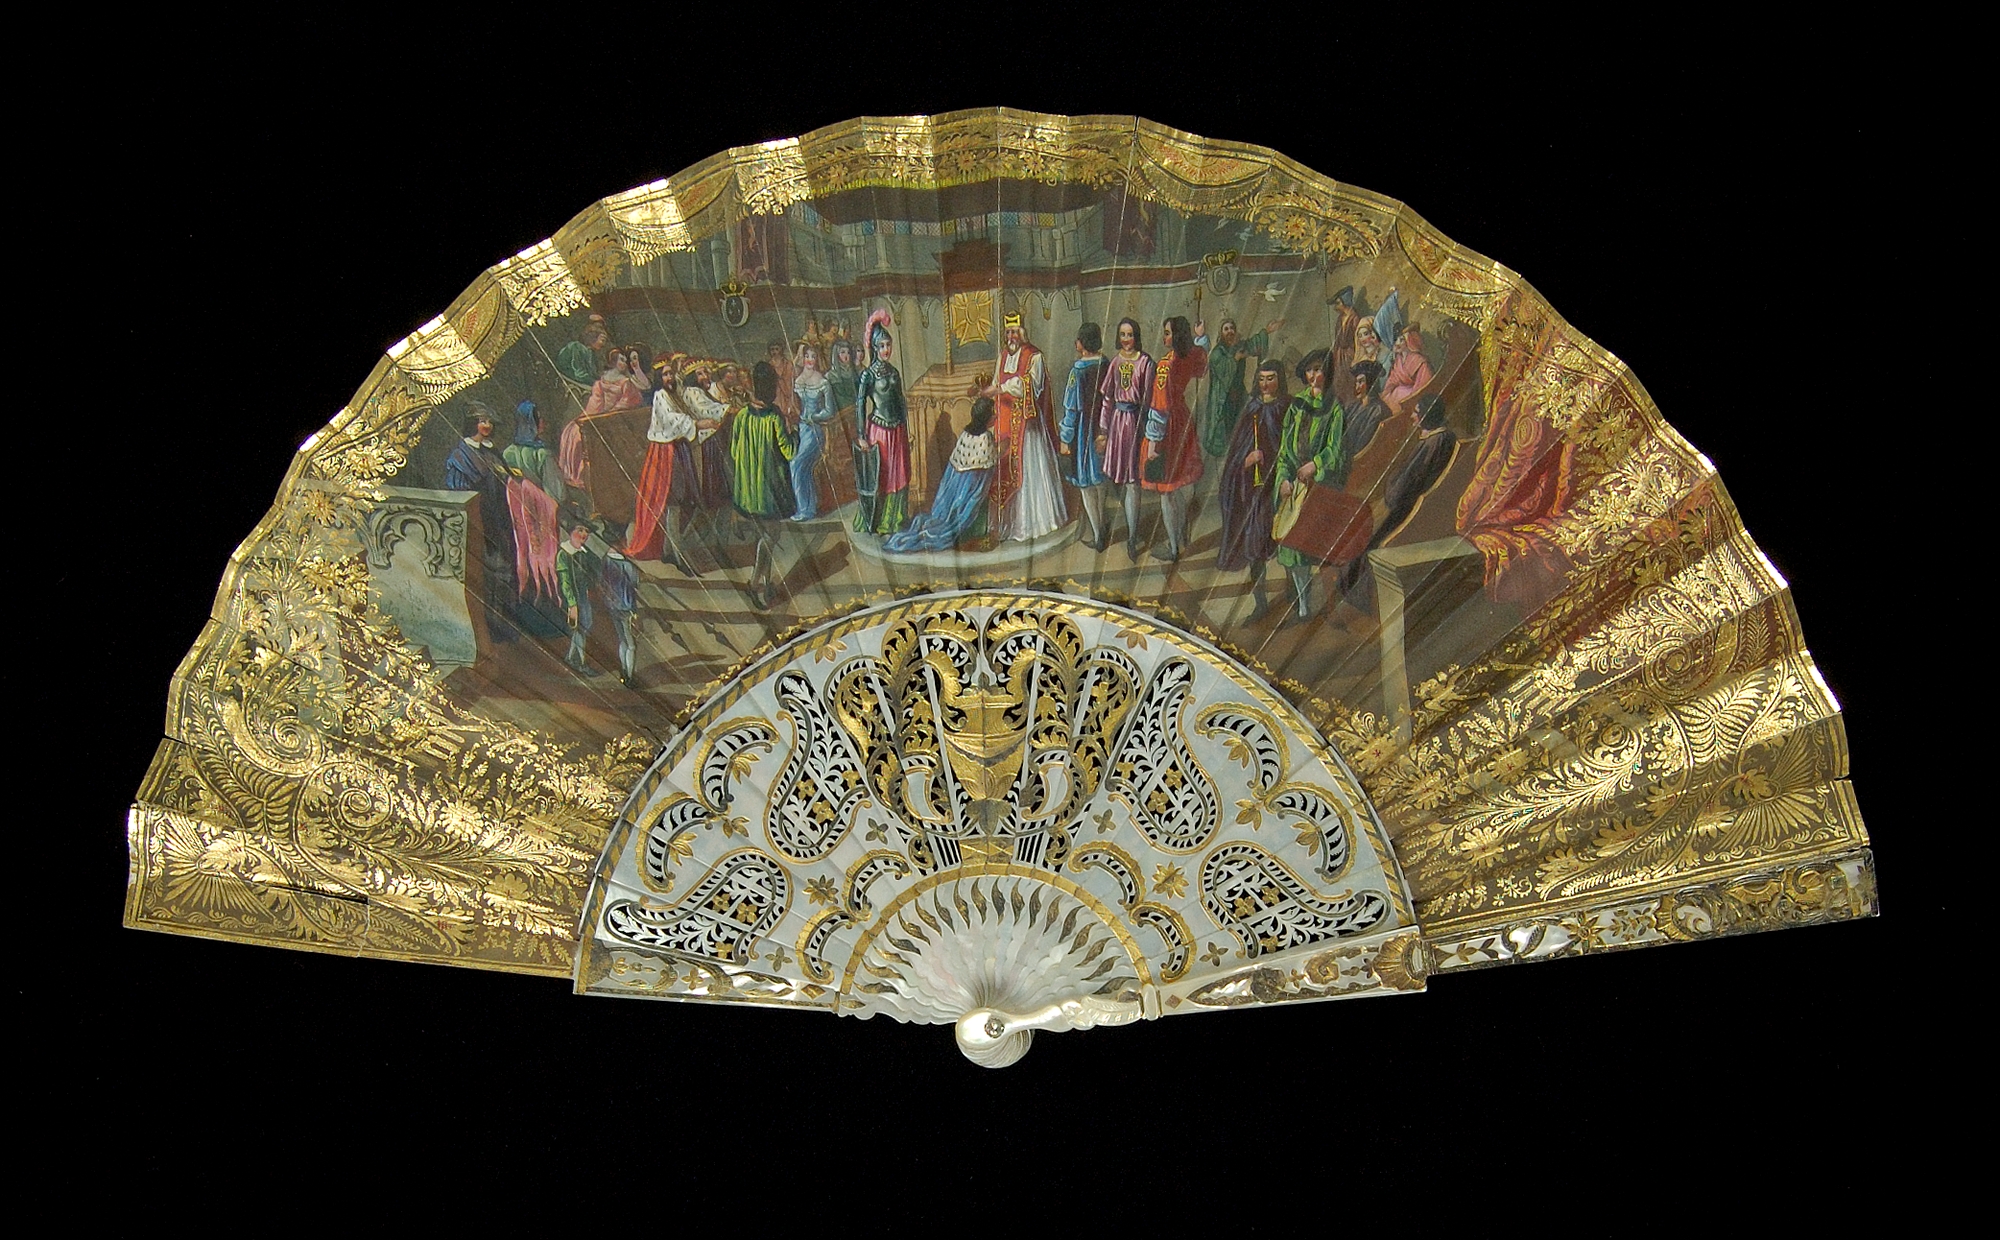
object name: fan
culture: european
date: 1855-1865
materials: mother of pearl, paper, parchment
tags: kings,men,women